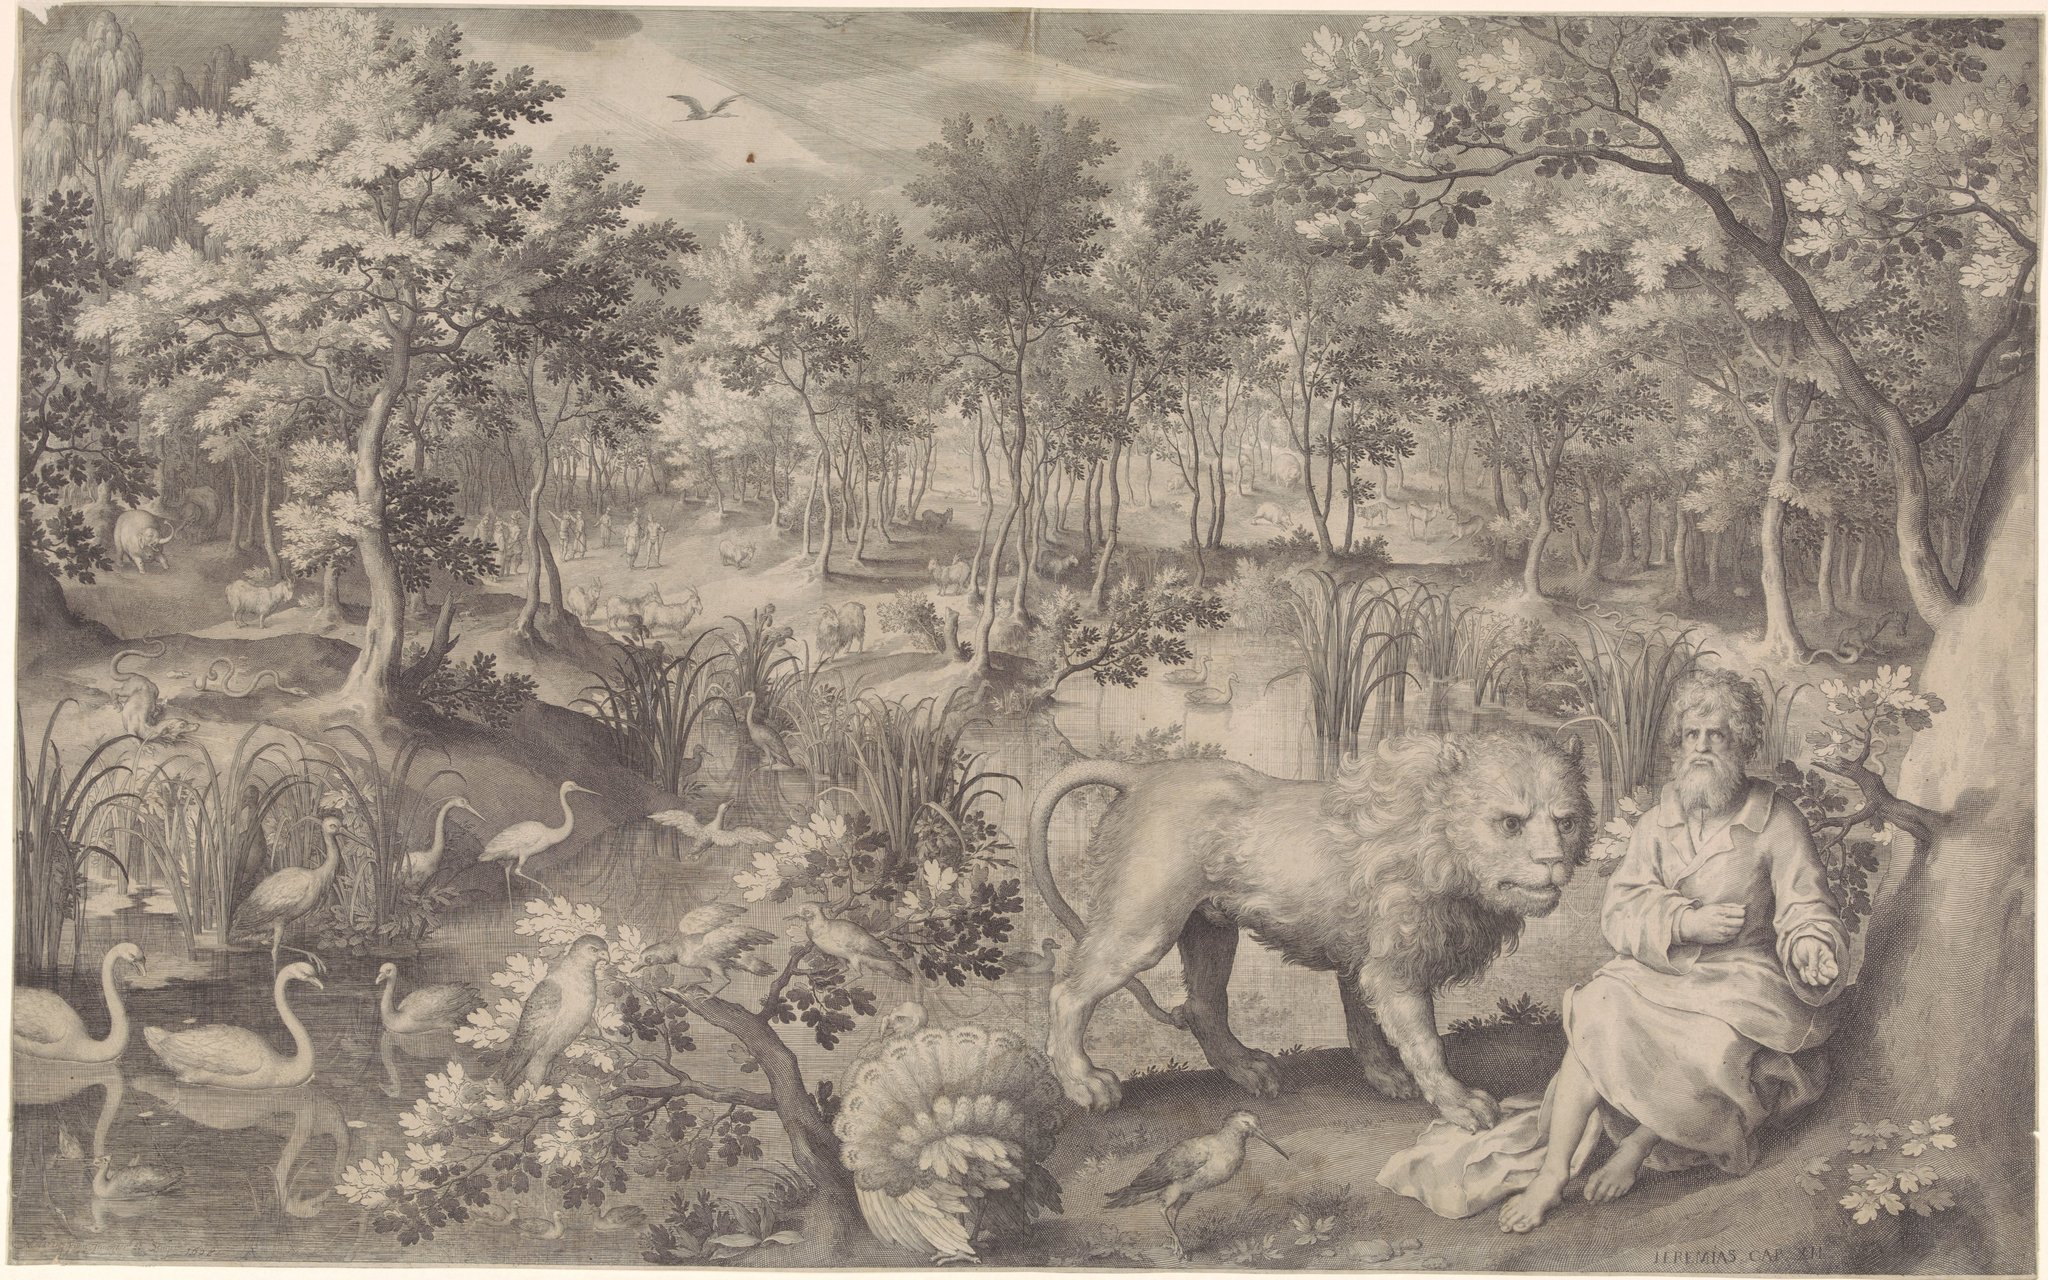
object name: print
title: Jeremia in de wildernis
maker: nicolaes de bruyn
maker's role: print maker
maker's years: 1571-1656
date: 1608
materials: paper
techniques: engraving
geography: antwerp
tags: other scenes ~ the book of jeremiah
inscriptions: collector's mark: Lugt 2228, collector's mark: Lugt 1114, collector's mark: Lugt 1238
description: De profeet Jeremia in de wildernis. Rondom hem verschillende wilde dieren, waaronder een leeuw. Een onderschrift bij de prent verwijst naar de profetie van Jeremia 12.